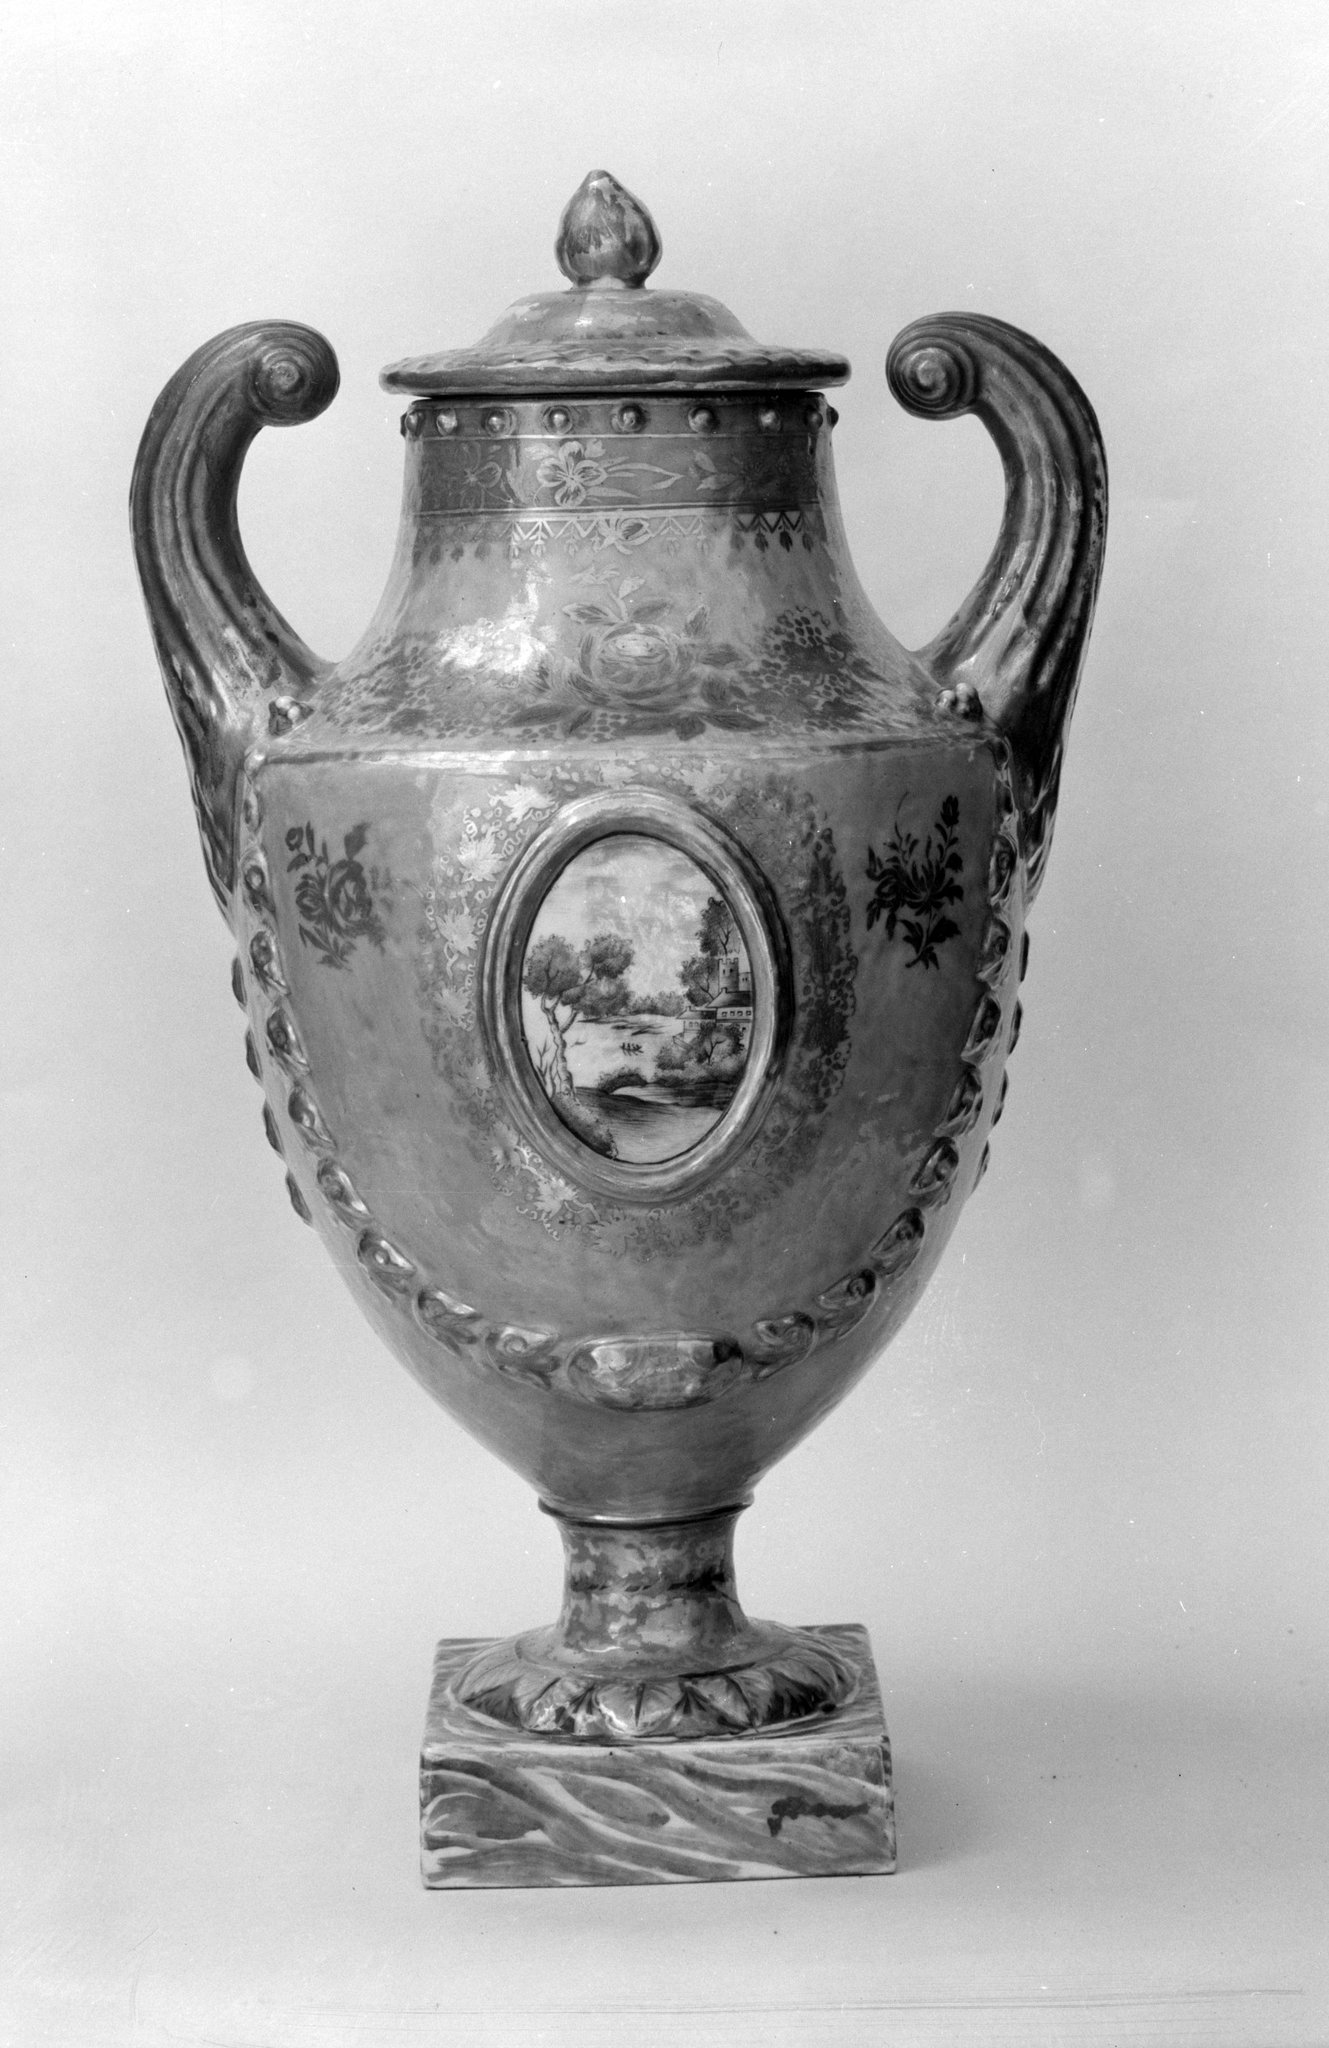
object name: urn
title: Covered Urn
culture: chinese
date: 1785-1815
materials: porcelain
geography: china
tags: landscapes